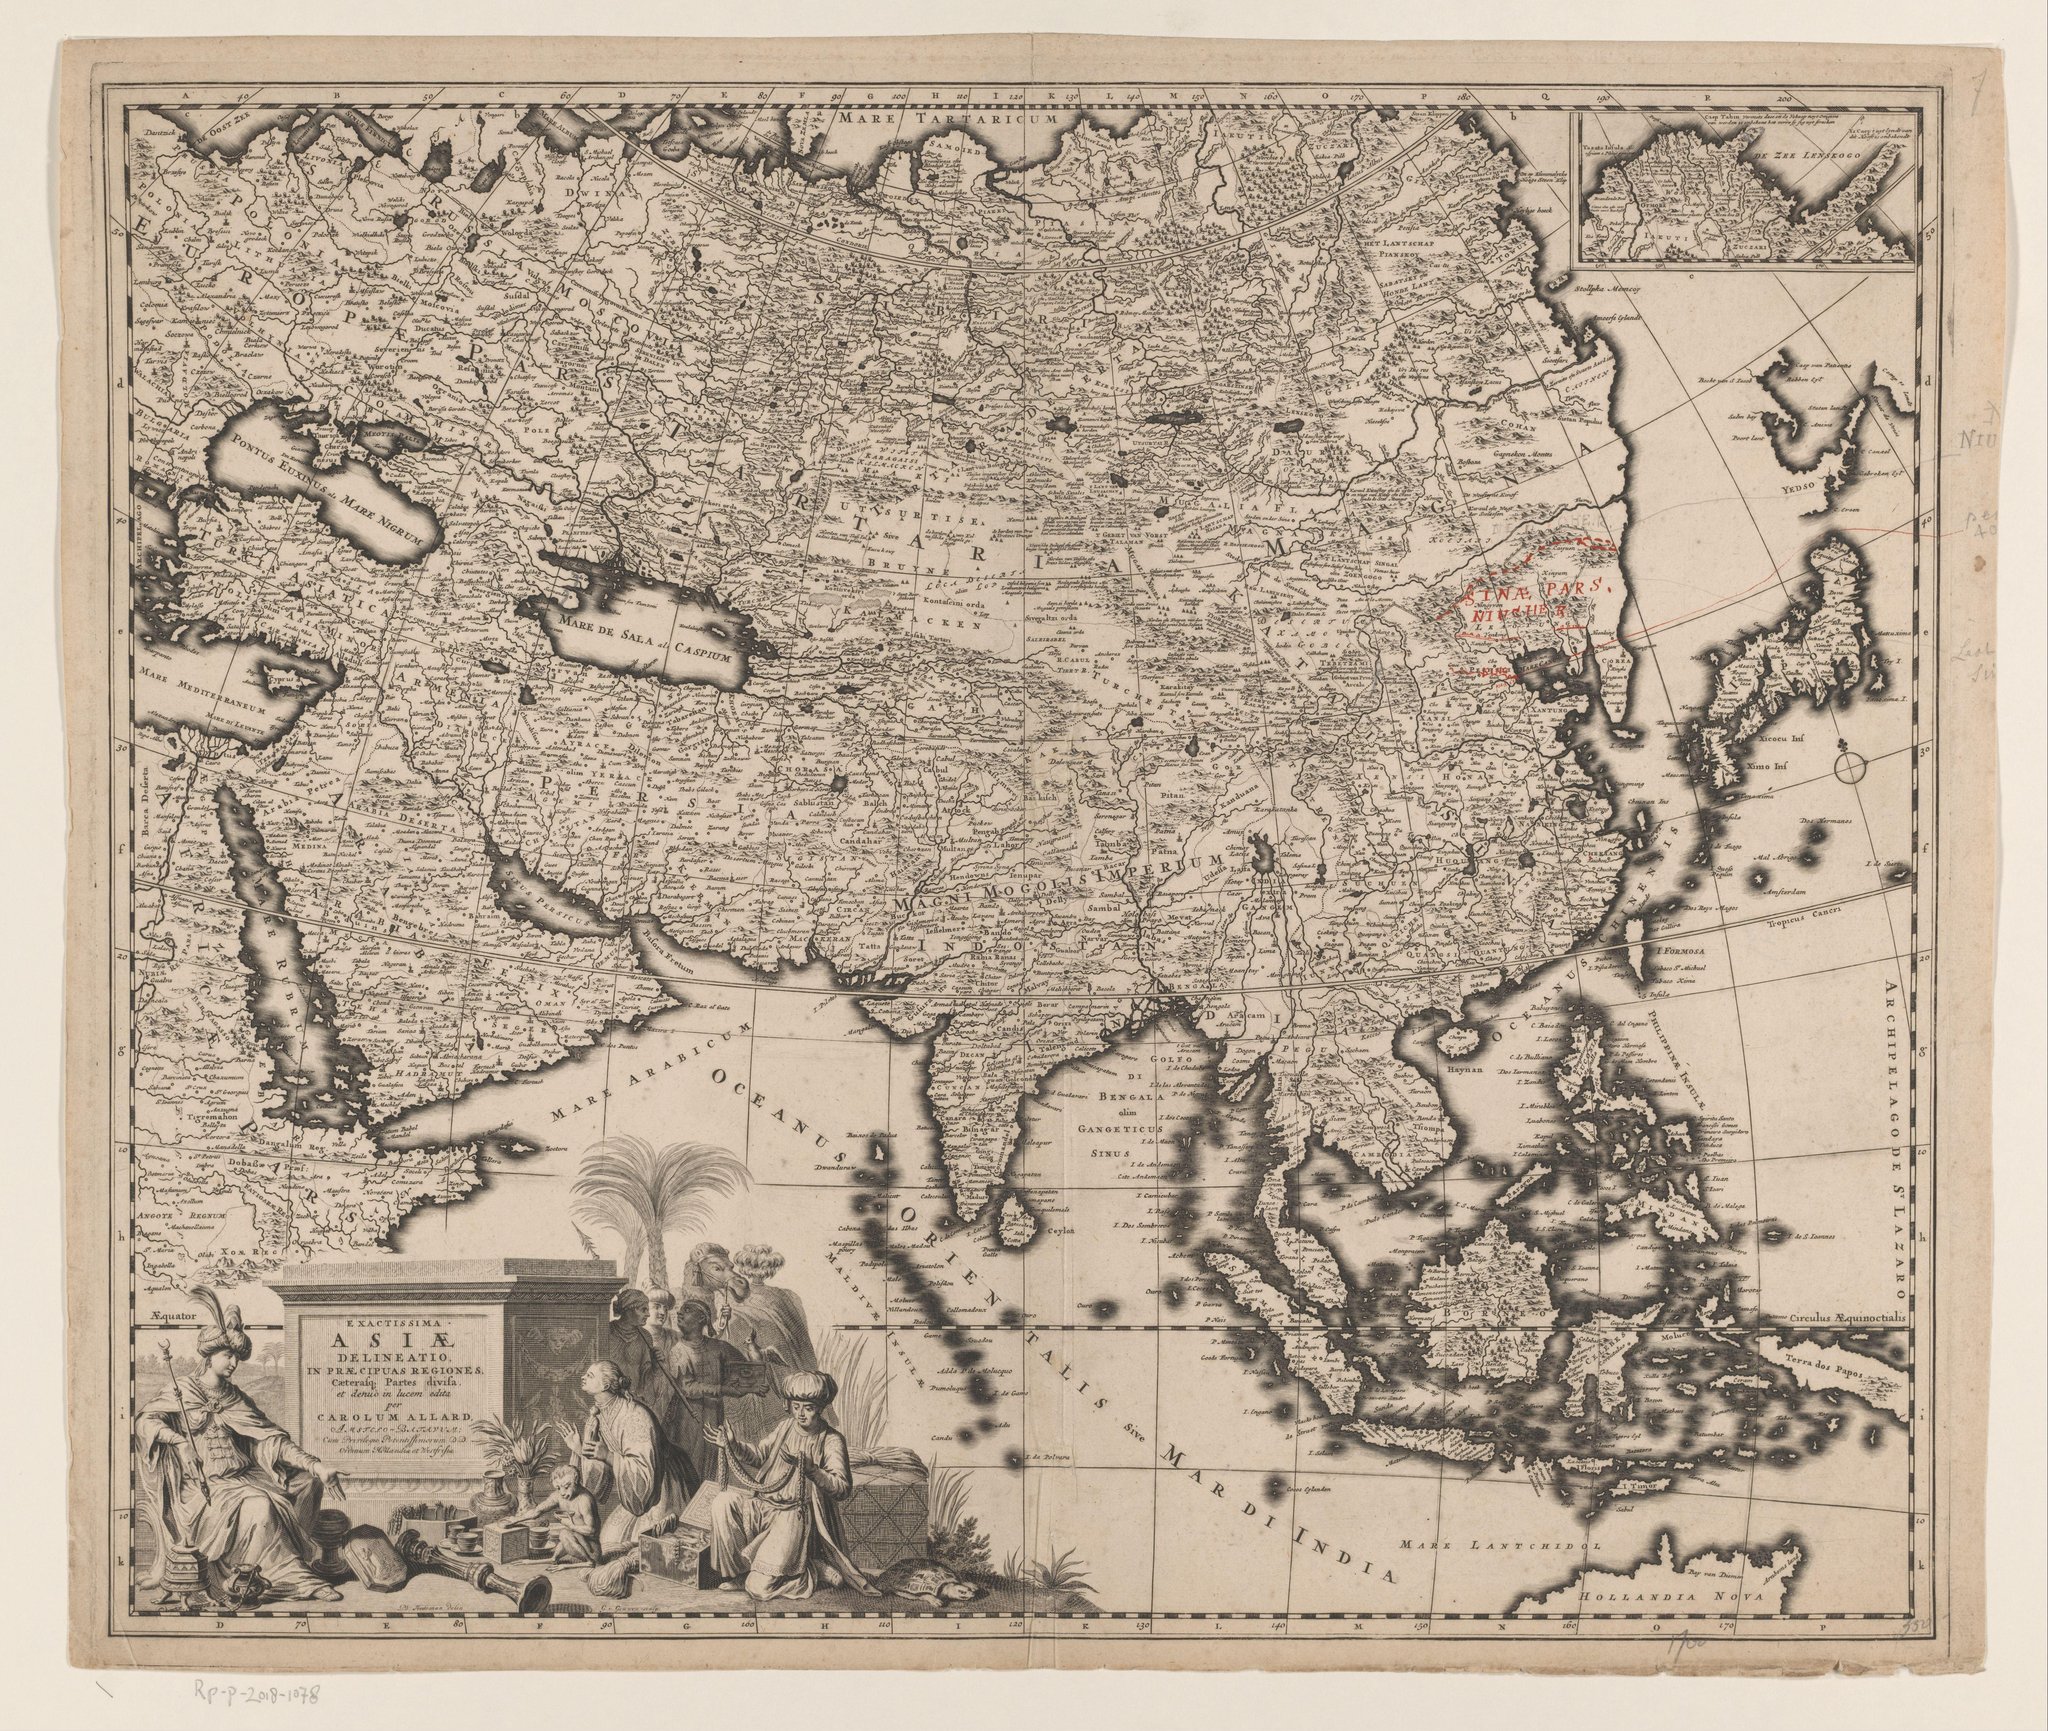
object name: print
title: Kaart van Azië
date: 1683-1709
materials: ink, paper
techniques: engraving, pen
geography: amsterdam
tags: (map of) asia, asia represented allegorically; 'asia' (ripa)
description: Met een allegorische voorstelling van Azië rond de titelcartouche.